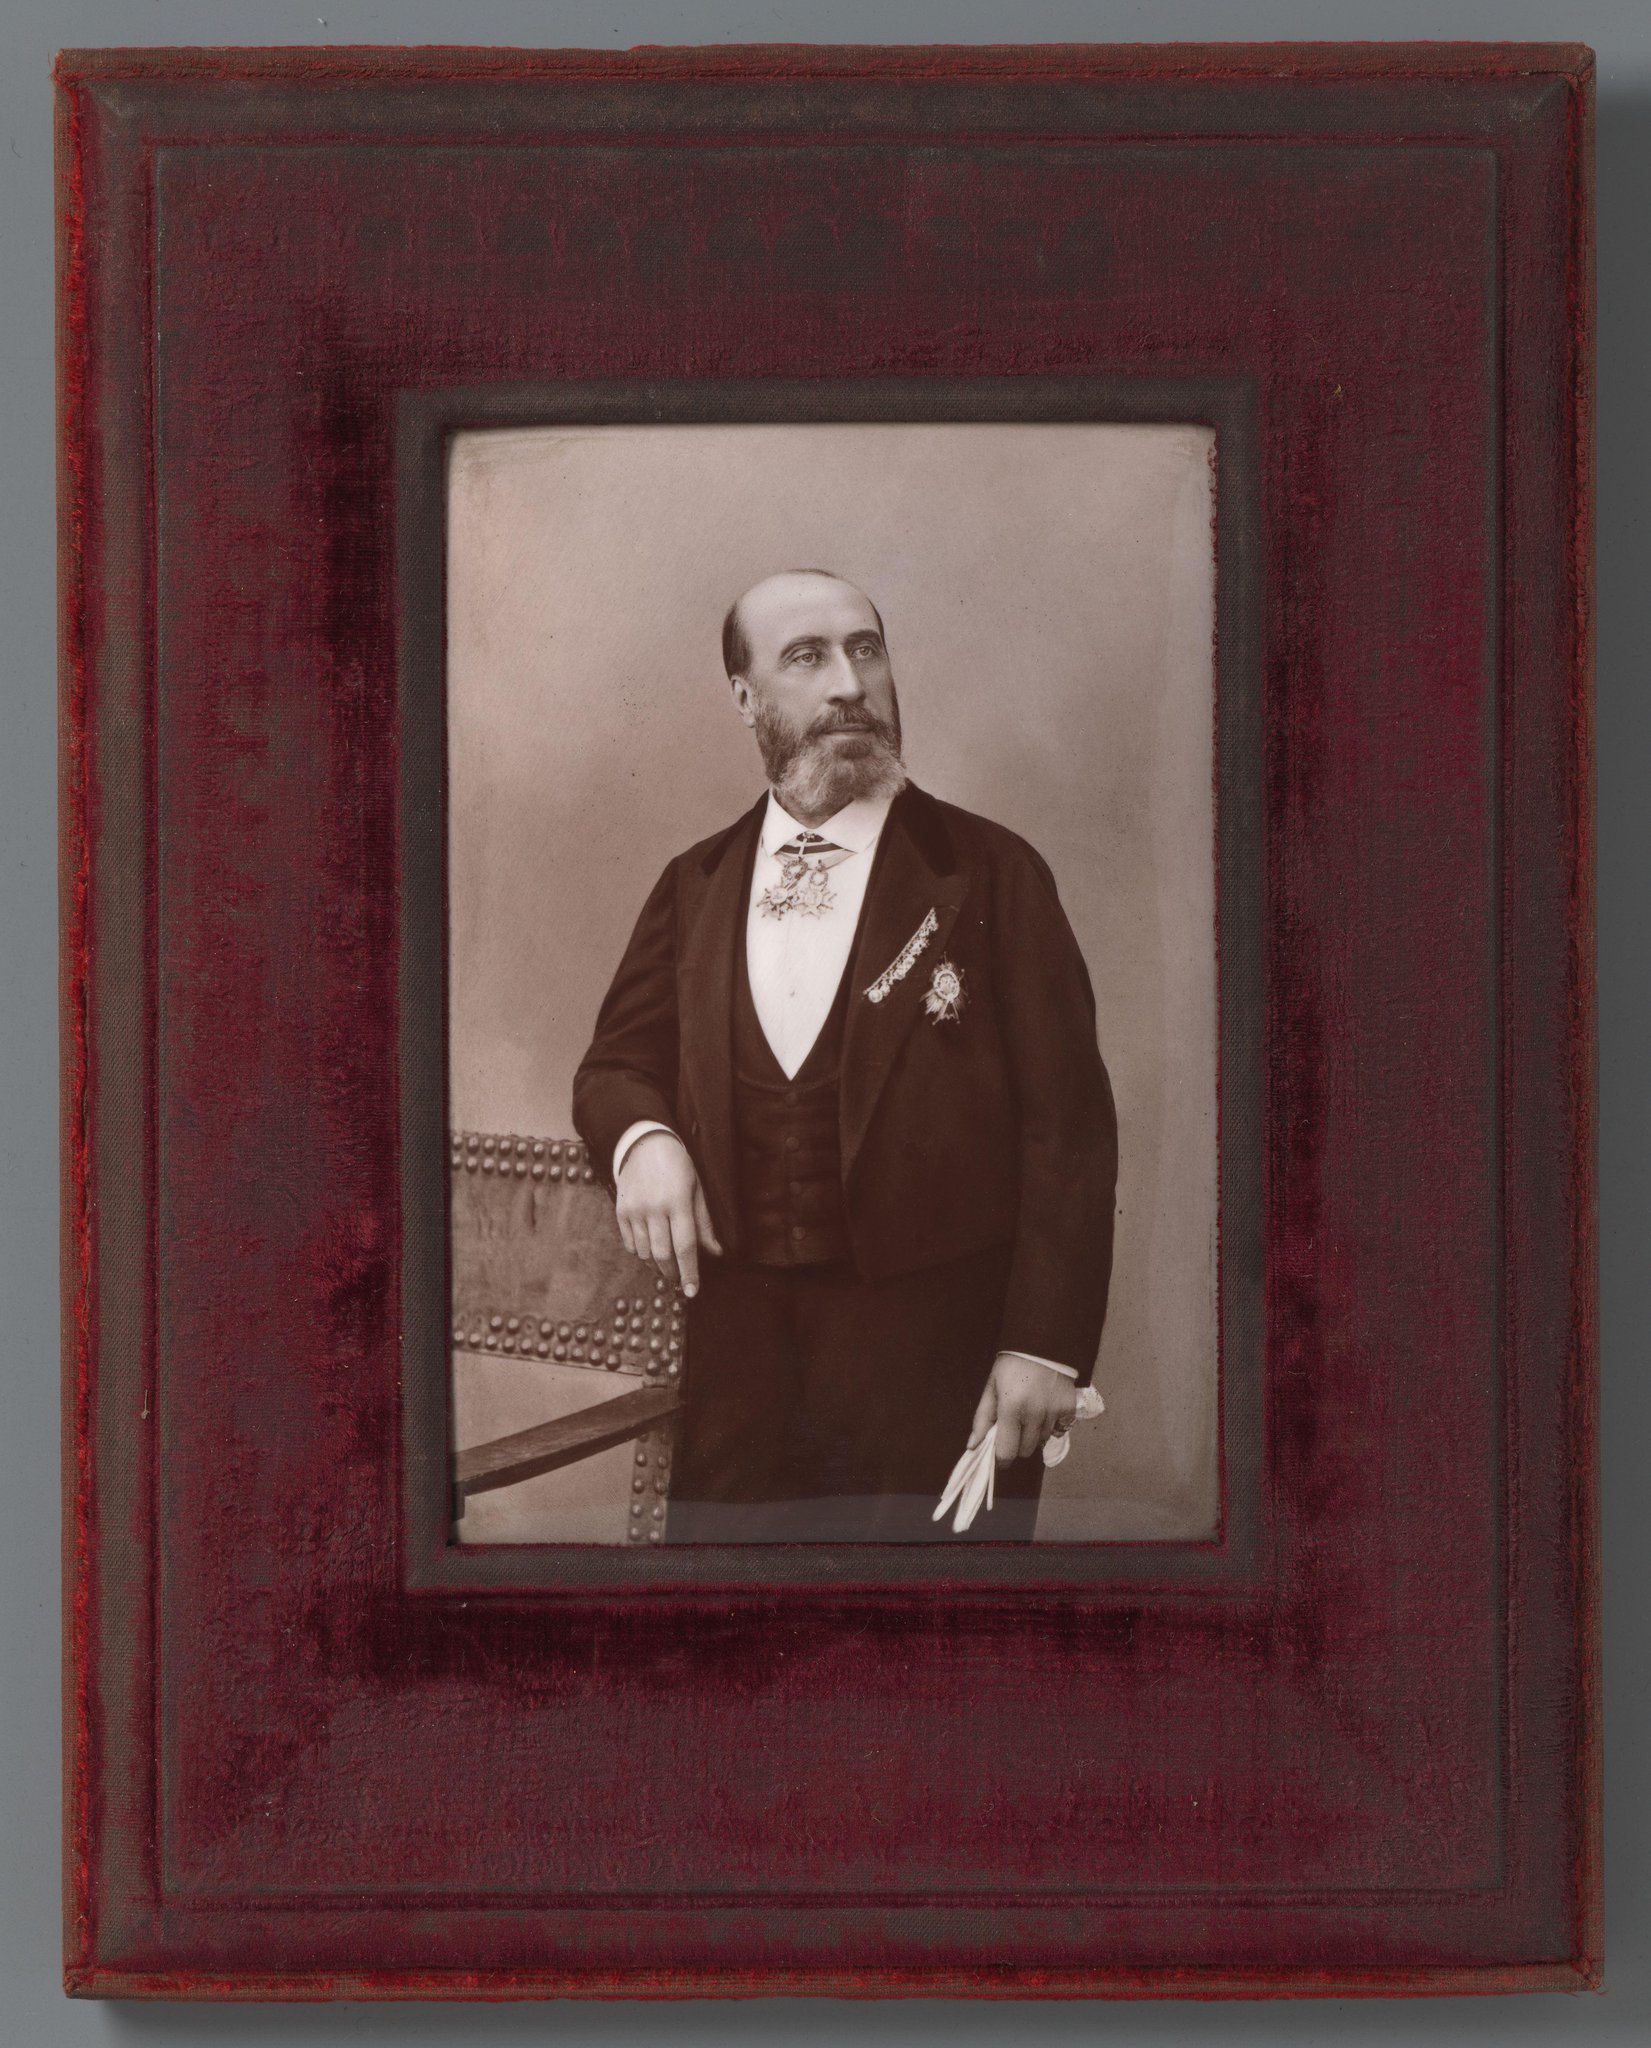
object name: photograph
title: Portret van een onbekende staande man met onderscheidingen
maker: félix nadar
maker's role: ballonvaarder, fotograaf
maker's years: 1820-1910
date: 1860-1899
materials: ceramic, velvet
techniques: photoceramics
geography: paris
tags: anonymous historical person portrayed